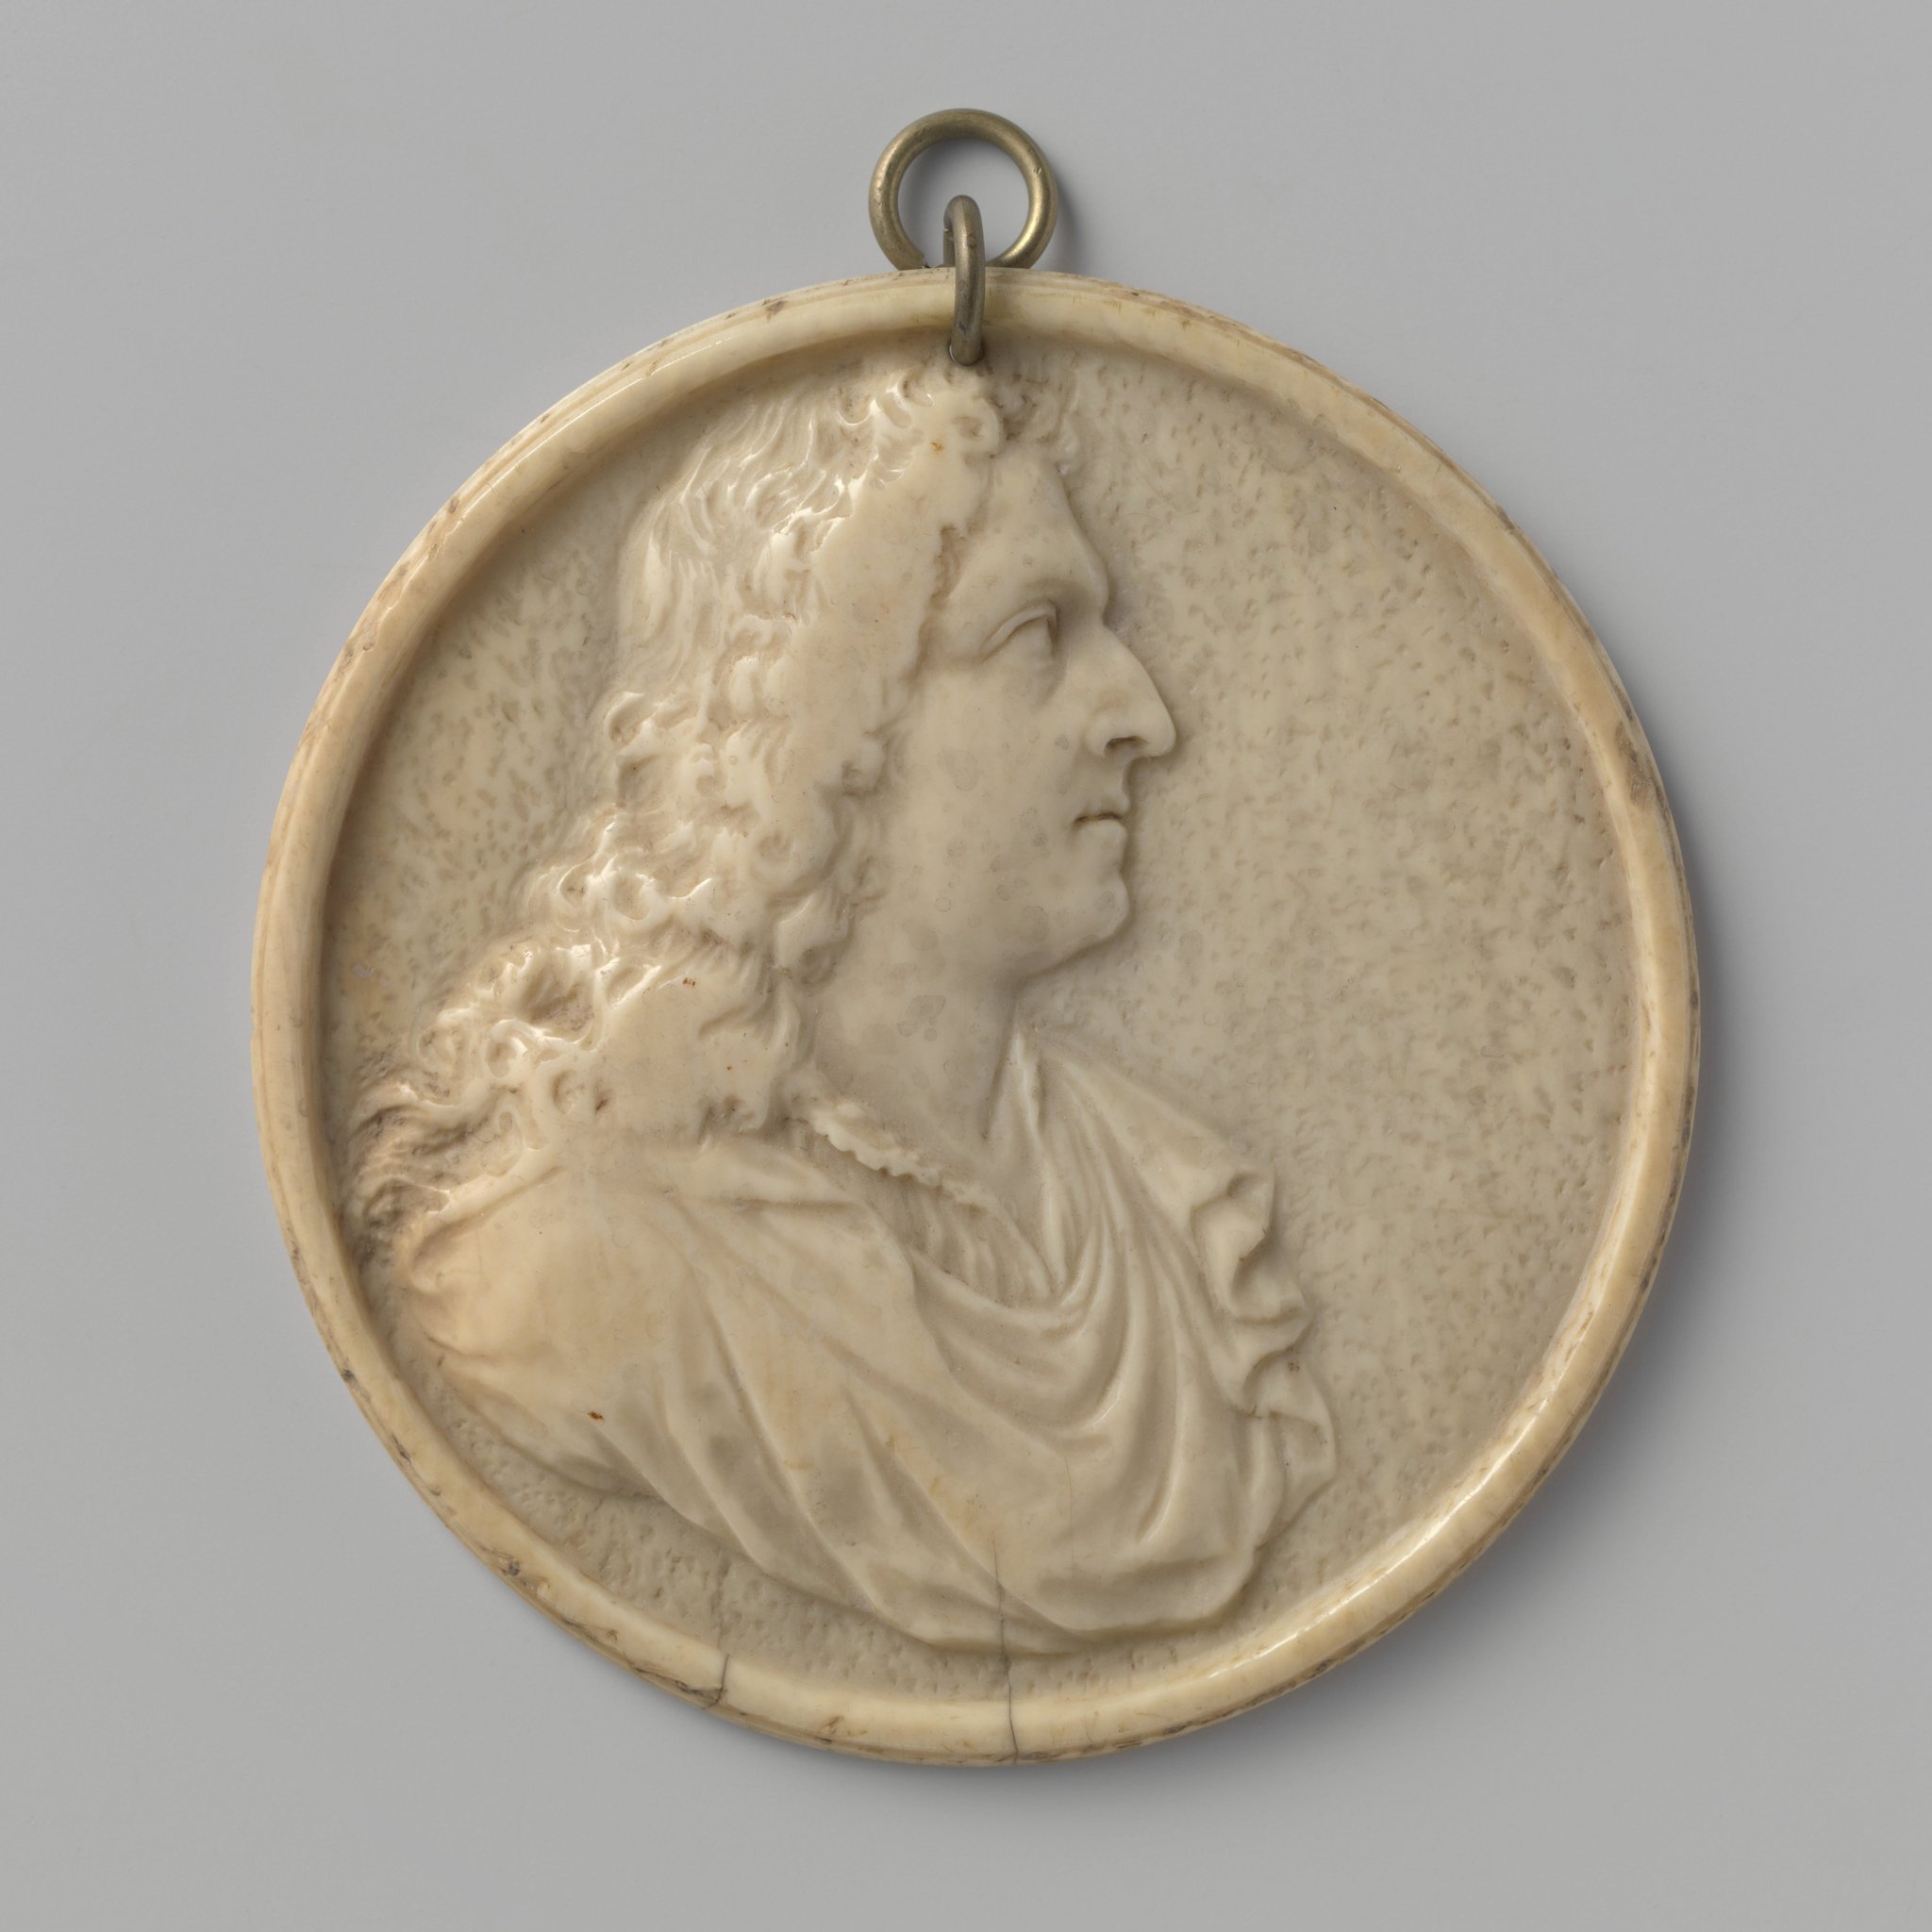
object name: locket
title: Portrait Medallion of a Man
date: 1690-1710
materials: ivory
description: Hij is in profiel naar rechts afgebeeld. Zijn krullende haar valt tot op de schouders. Het openstaande hemd wordt grotendeels bedekt door een draperie.